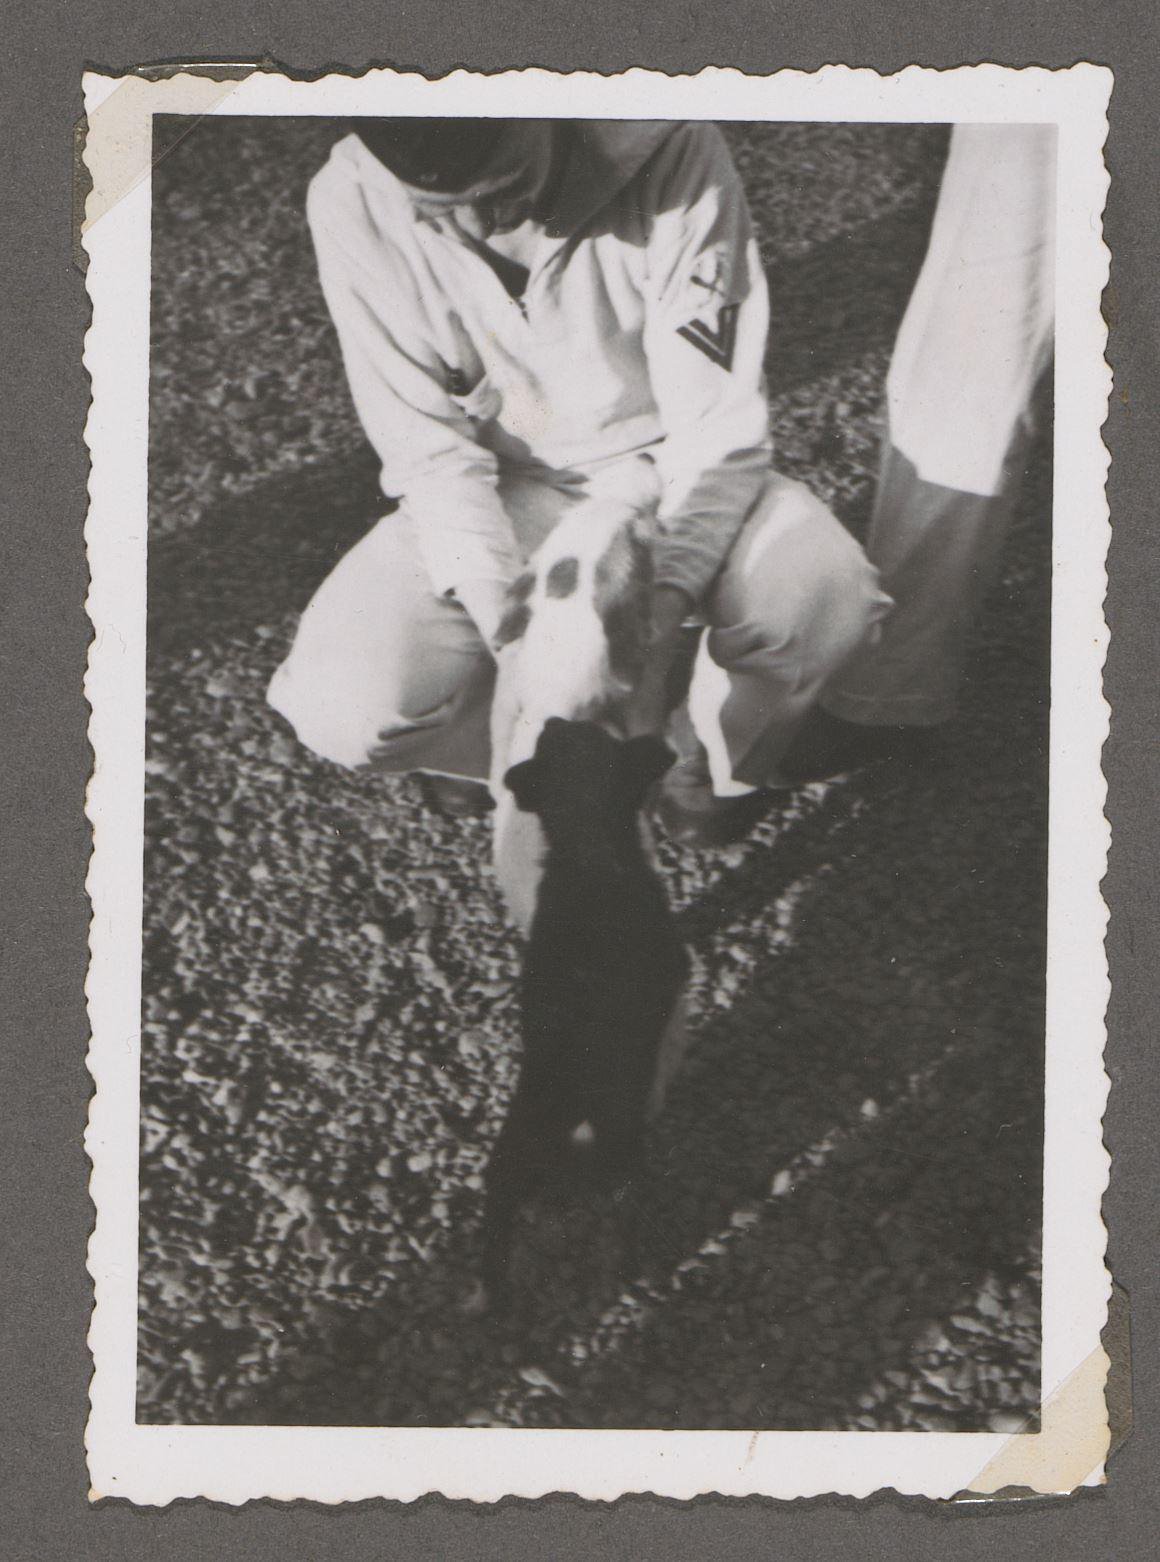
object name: photograph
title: Portret van een militair in uniform met hond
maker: Anonymous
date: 1941-1945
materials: paper, photographic support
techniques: gelatin silver print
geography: netherlands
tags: the soldier; the soldier's life, (military) uniforms, dog, netherlands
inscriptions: annotation: ‘"Emmes" mit seinem Bebby’